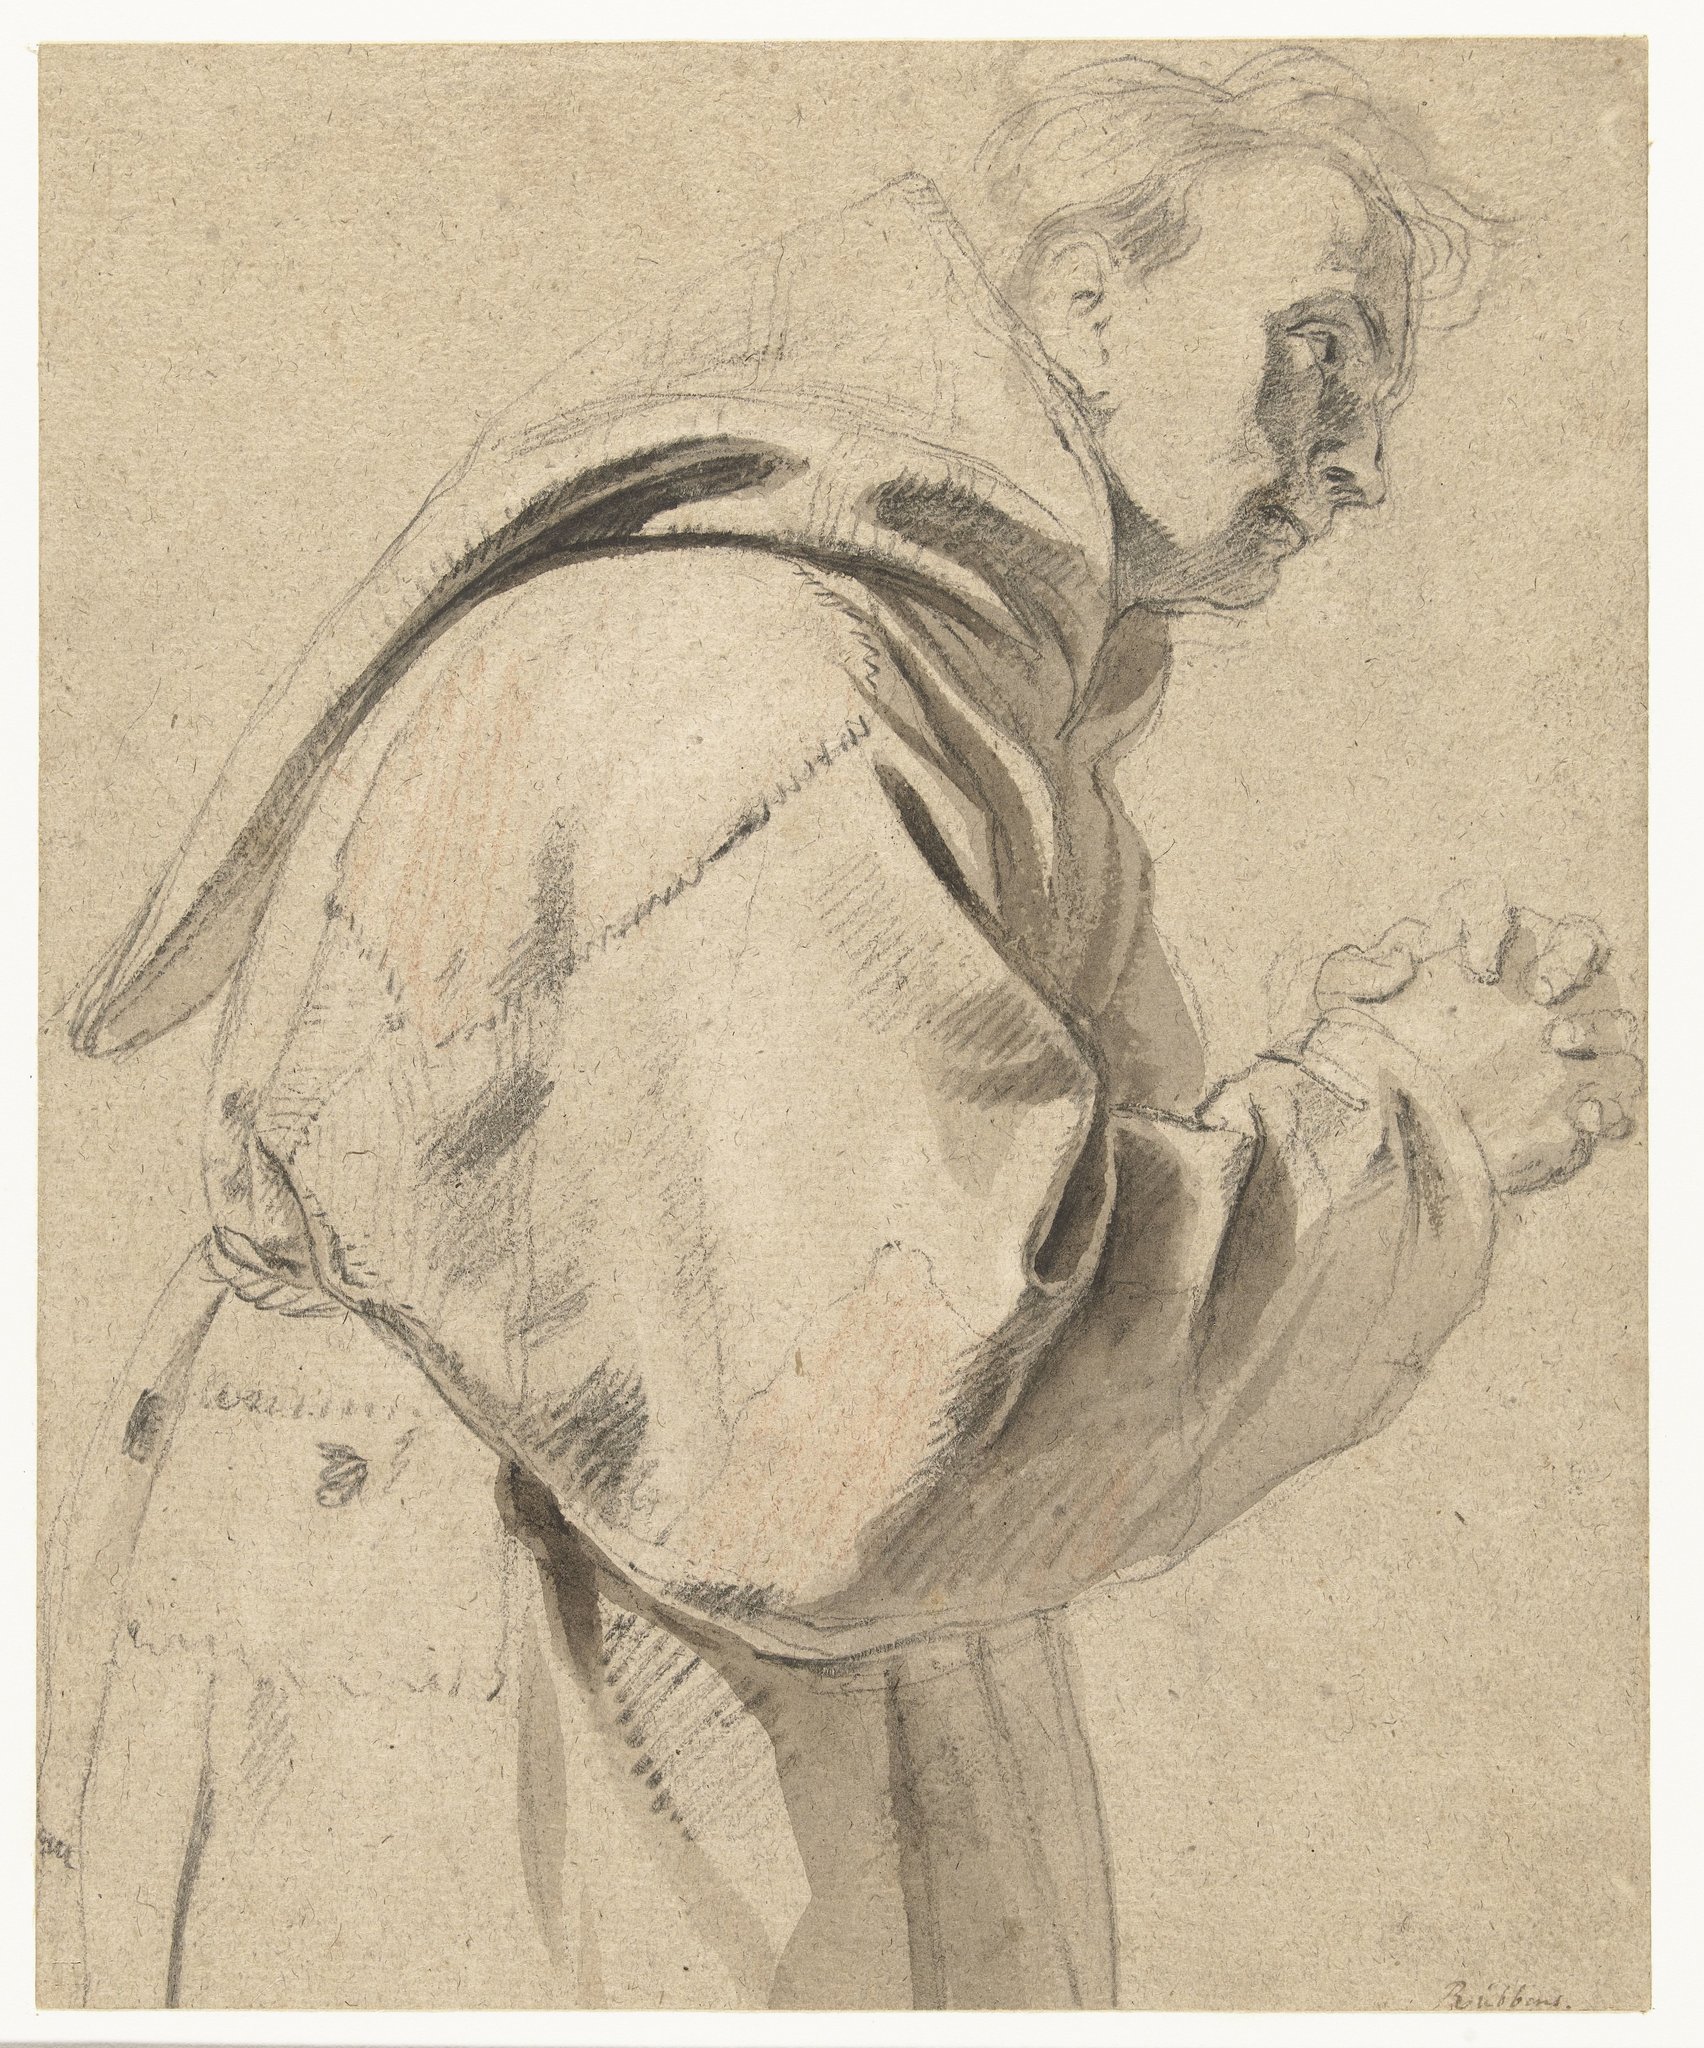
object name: drawing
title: Monnik, rechts in profiel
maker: peter paul rubens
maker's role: draughtsman, painter, print maker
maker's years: 1577-1640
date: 1587-1640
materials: chalk, paper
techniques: brush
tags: monk(s), friar(s)